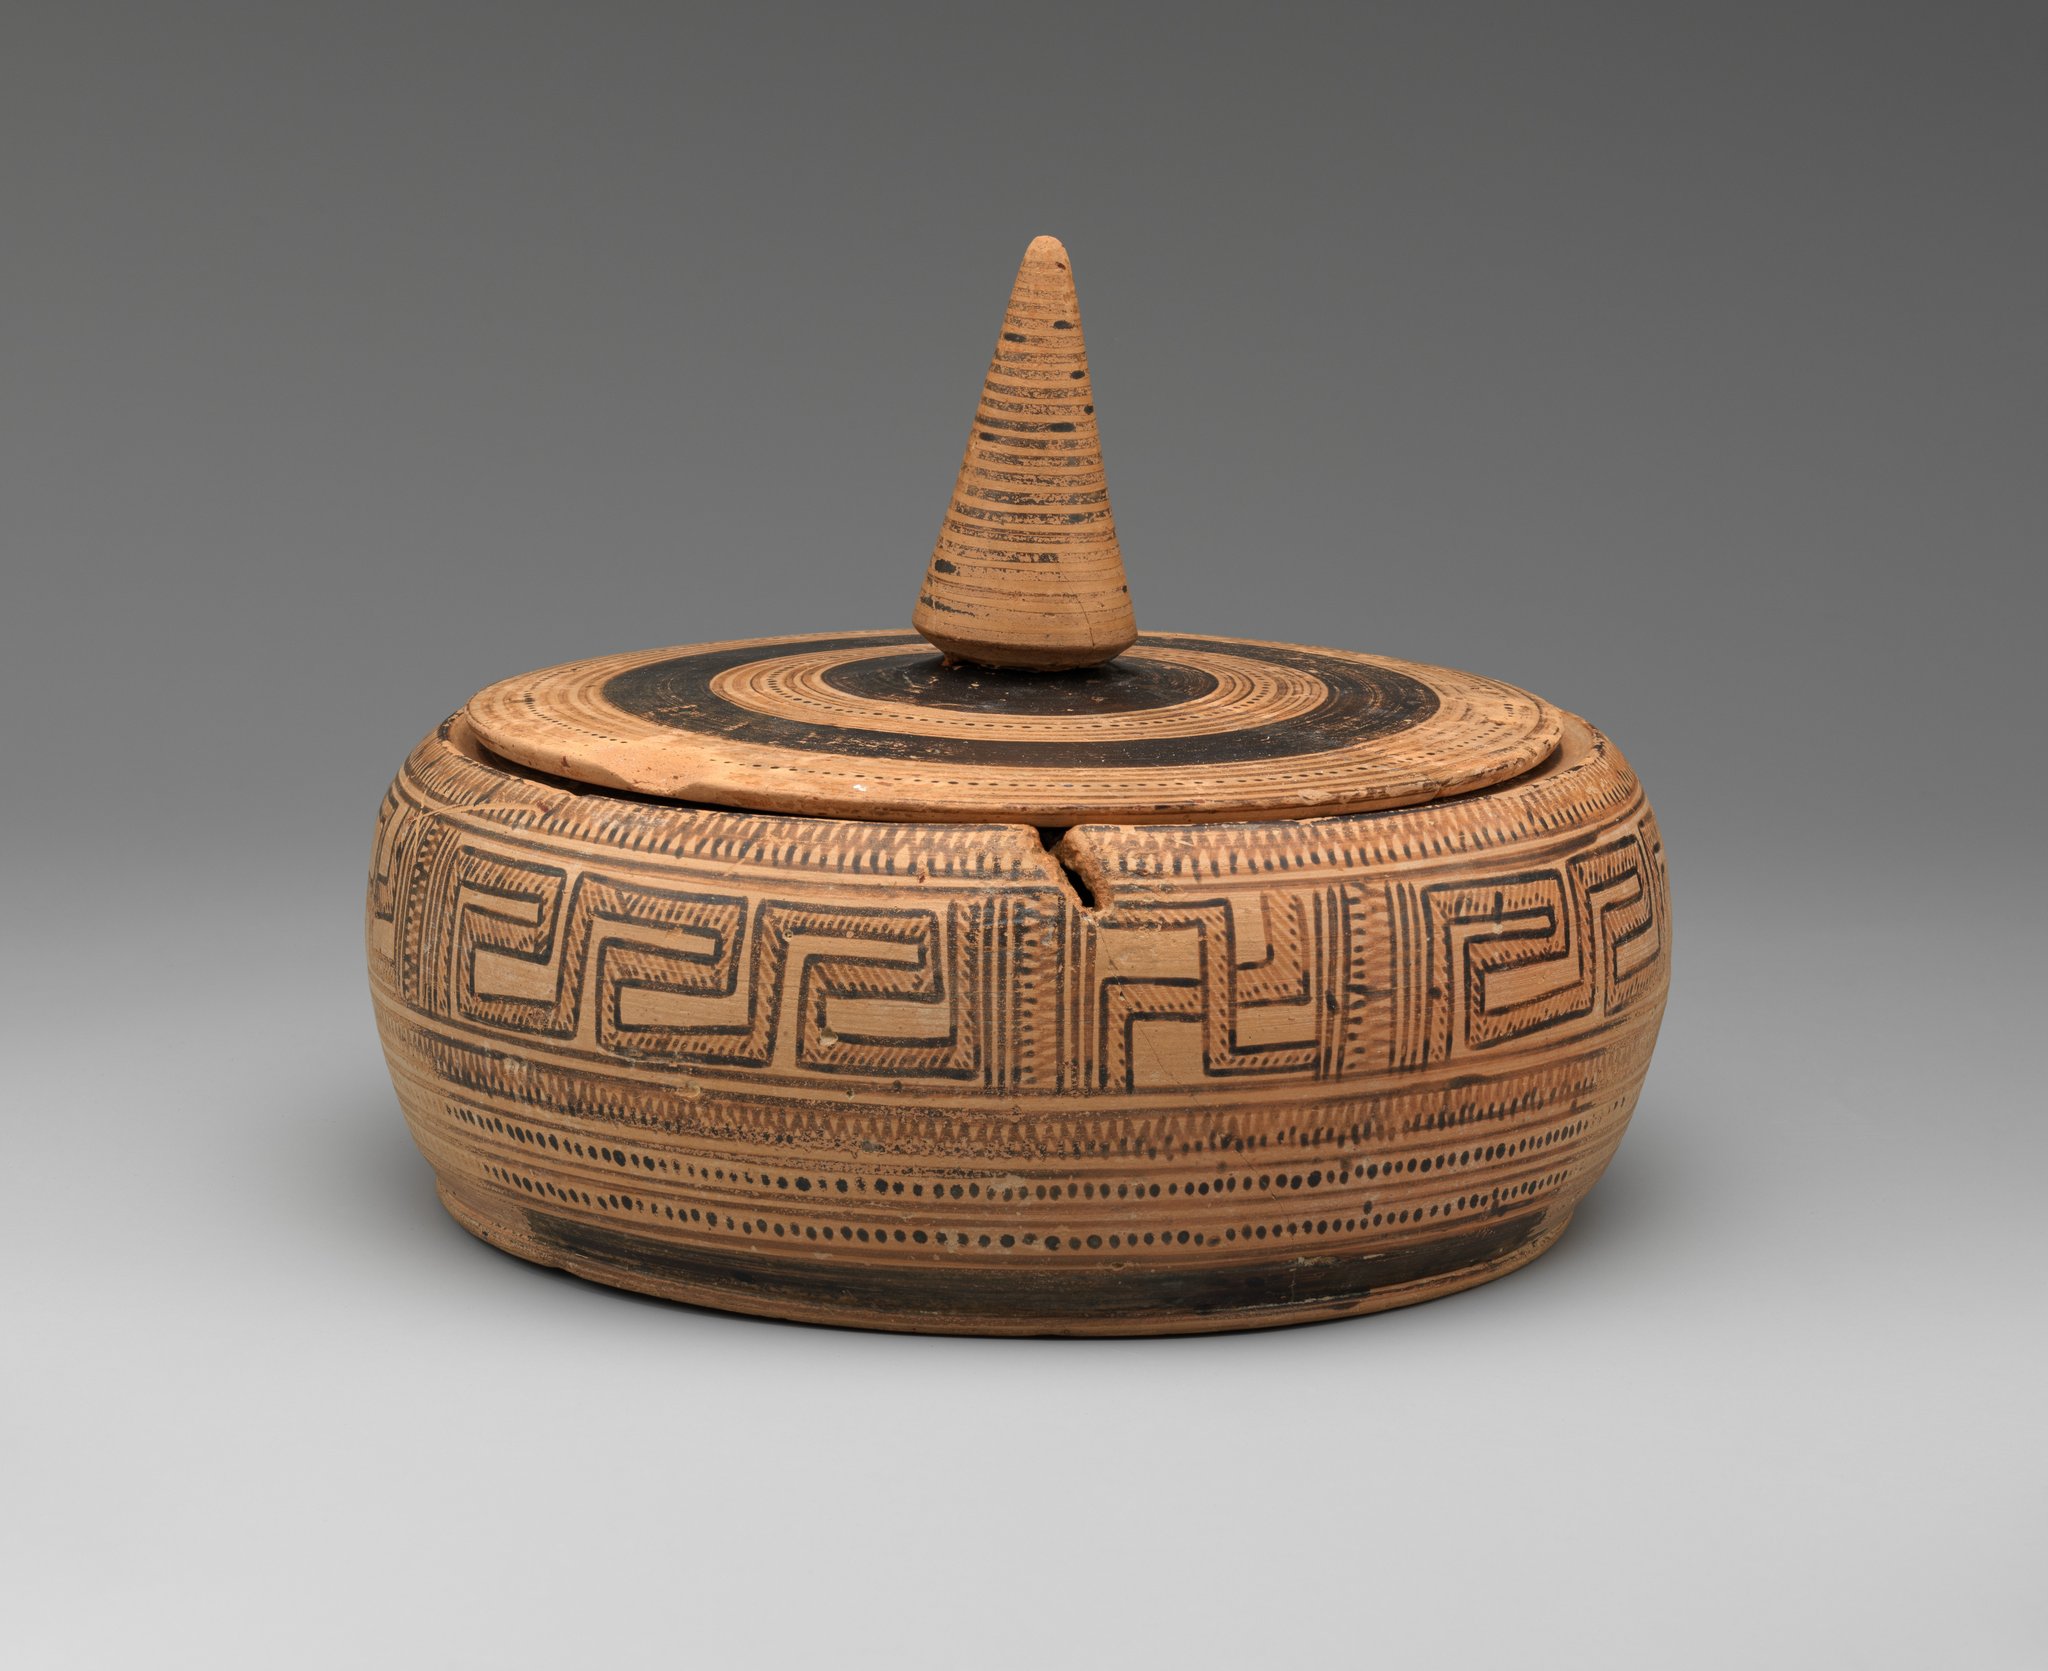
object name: pyxis with lid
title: Terracotta pyxis (box with lid)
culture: greek, attic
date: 750 BCE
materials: terracotta